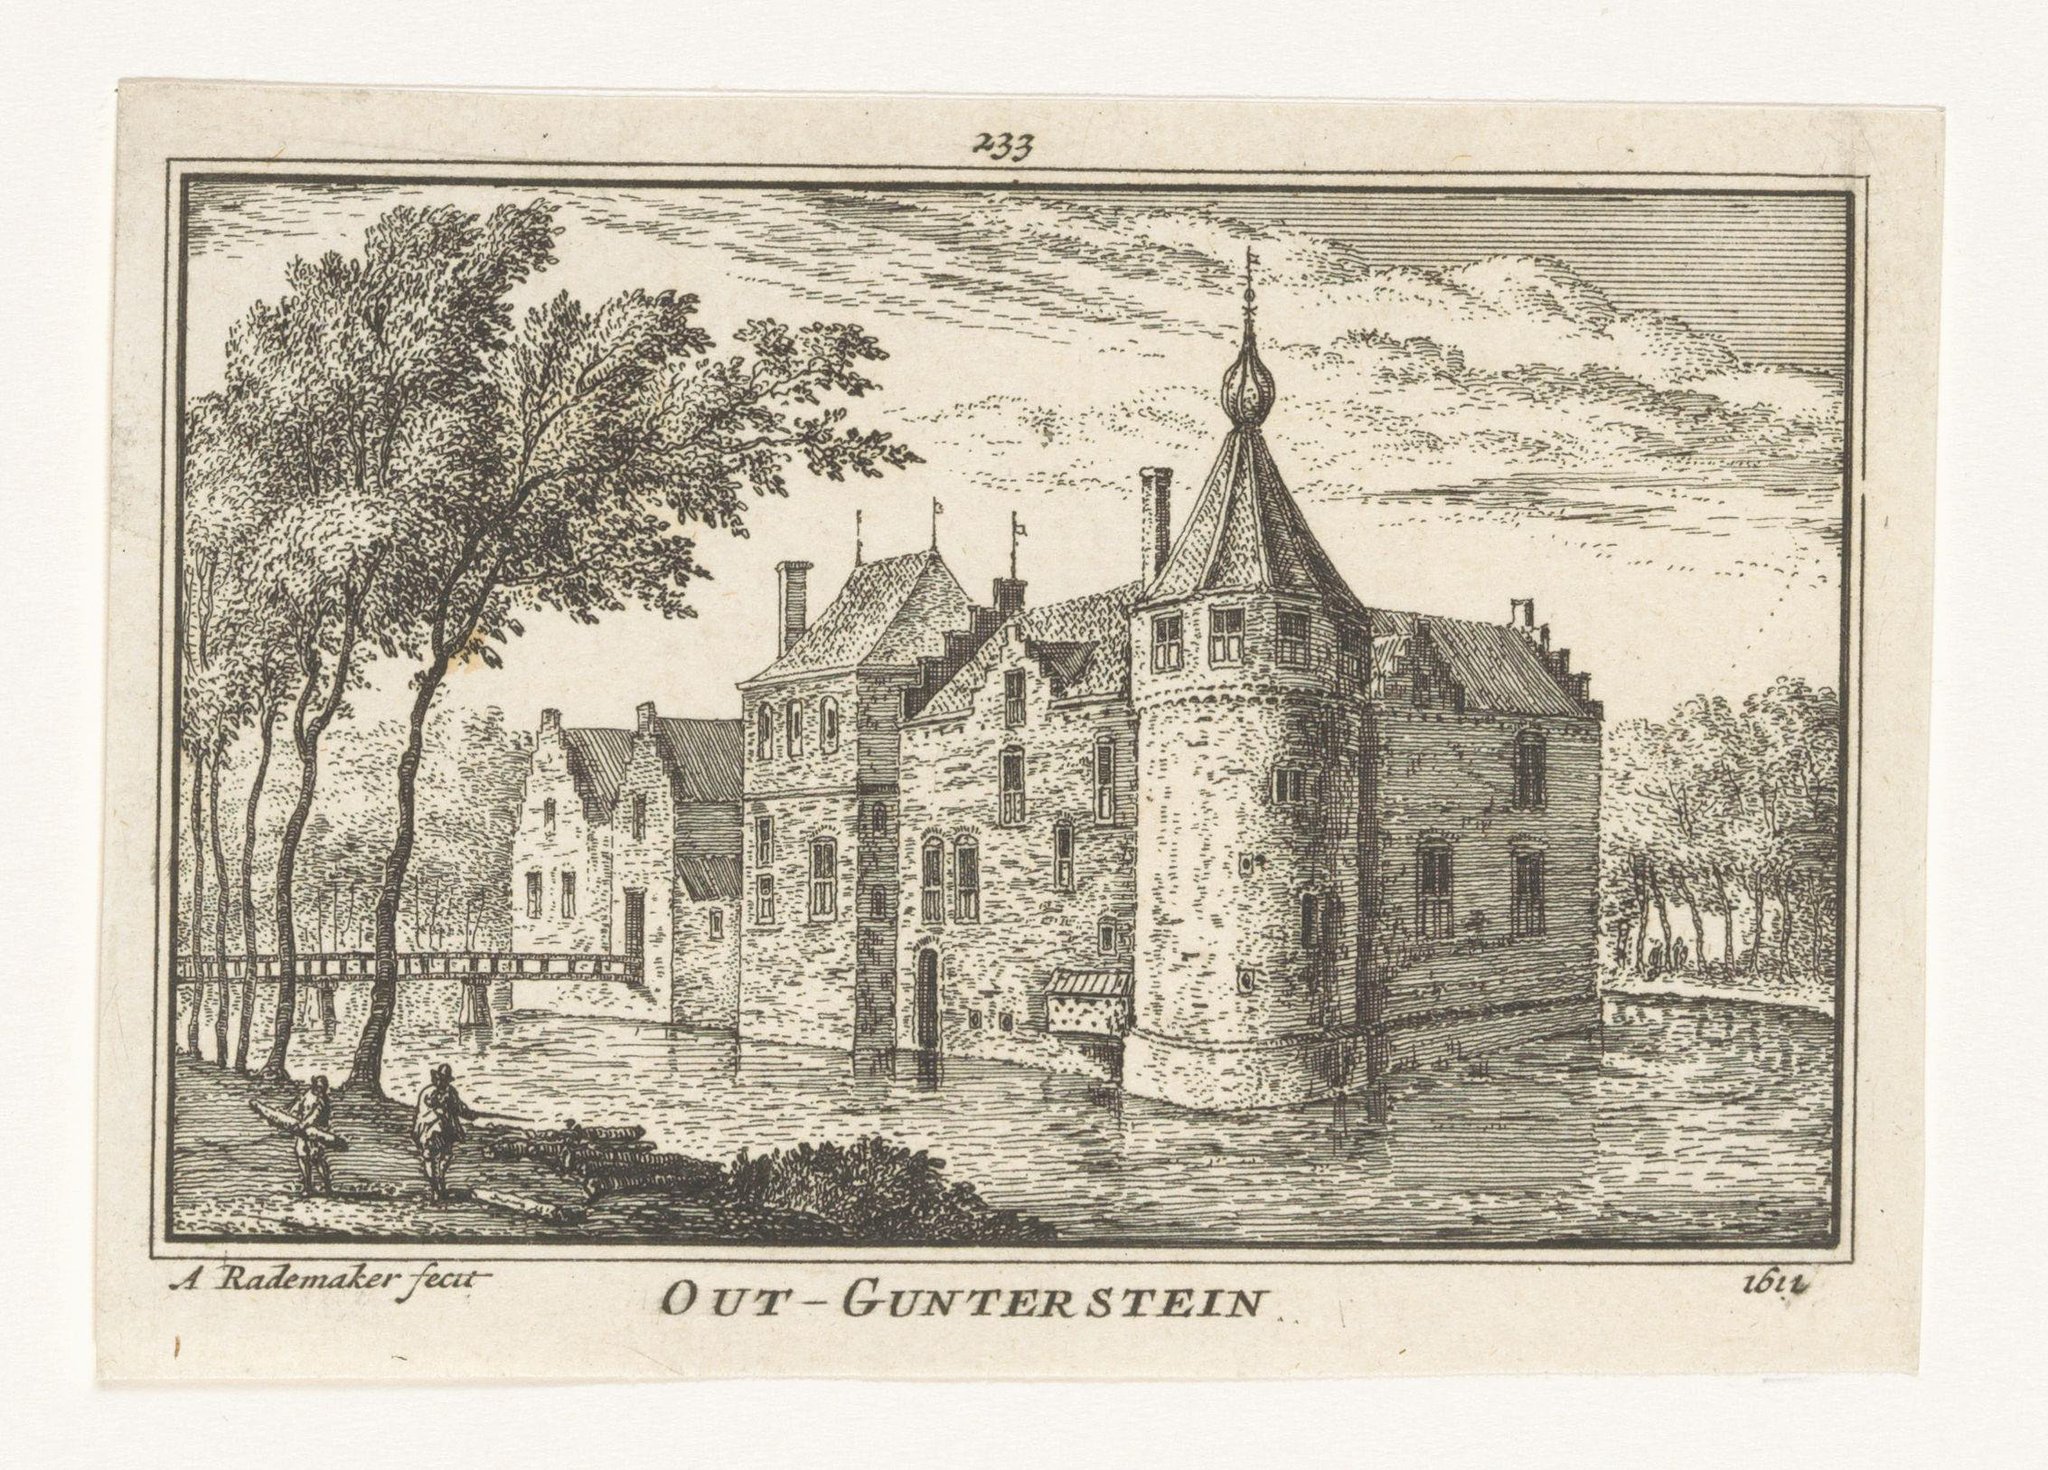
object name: book illustration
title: Out-Gunterstein 1611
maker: abraham rademaker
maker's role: draughtsman, print maker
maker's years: 1676-1735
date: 1725-1803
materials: paper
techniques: engraving, etching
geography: amsterdam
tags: sailing-ship, sailing-boat, bridge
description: Prent ook gebruikt in: Rademaker, Abraham. Kabinet van Nederlandsche outheden en gezichten: vervat in 300 konstplaaten (…). 2 delen. Amsterdam: Willem Barents, 1725, dl. 2, ill. 233. Na 1725 is deze prent nog in verschillende heruitgaven verschenen, uitgegeven in 1727-1733, 1770-1771 en 1792-1803. Uit welke uitgave het huidige exemplaar precies komt is niet na te gaan.